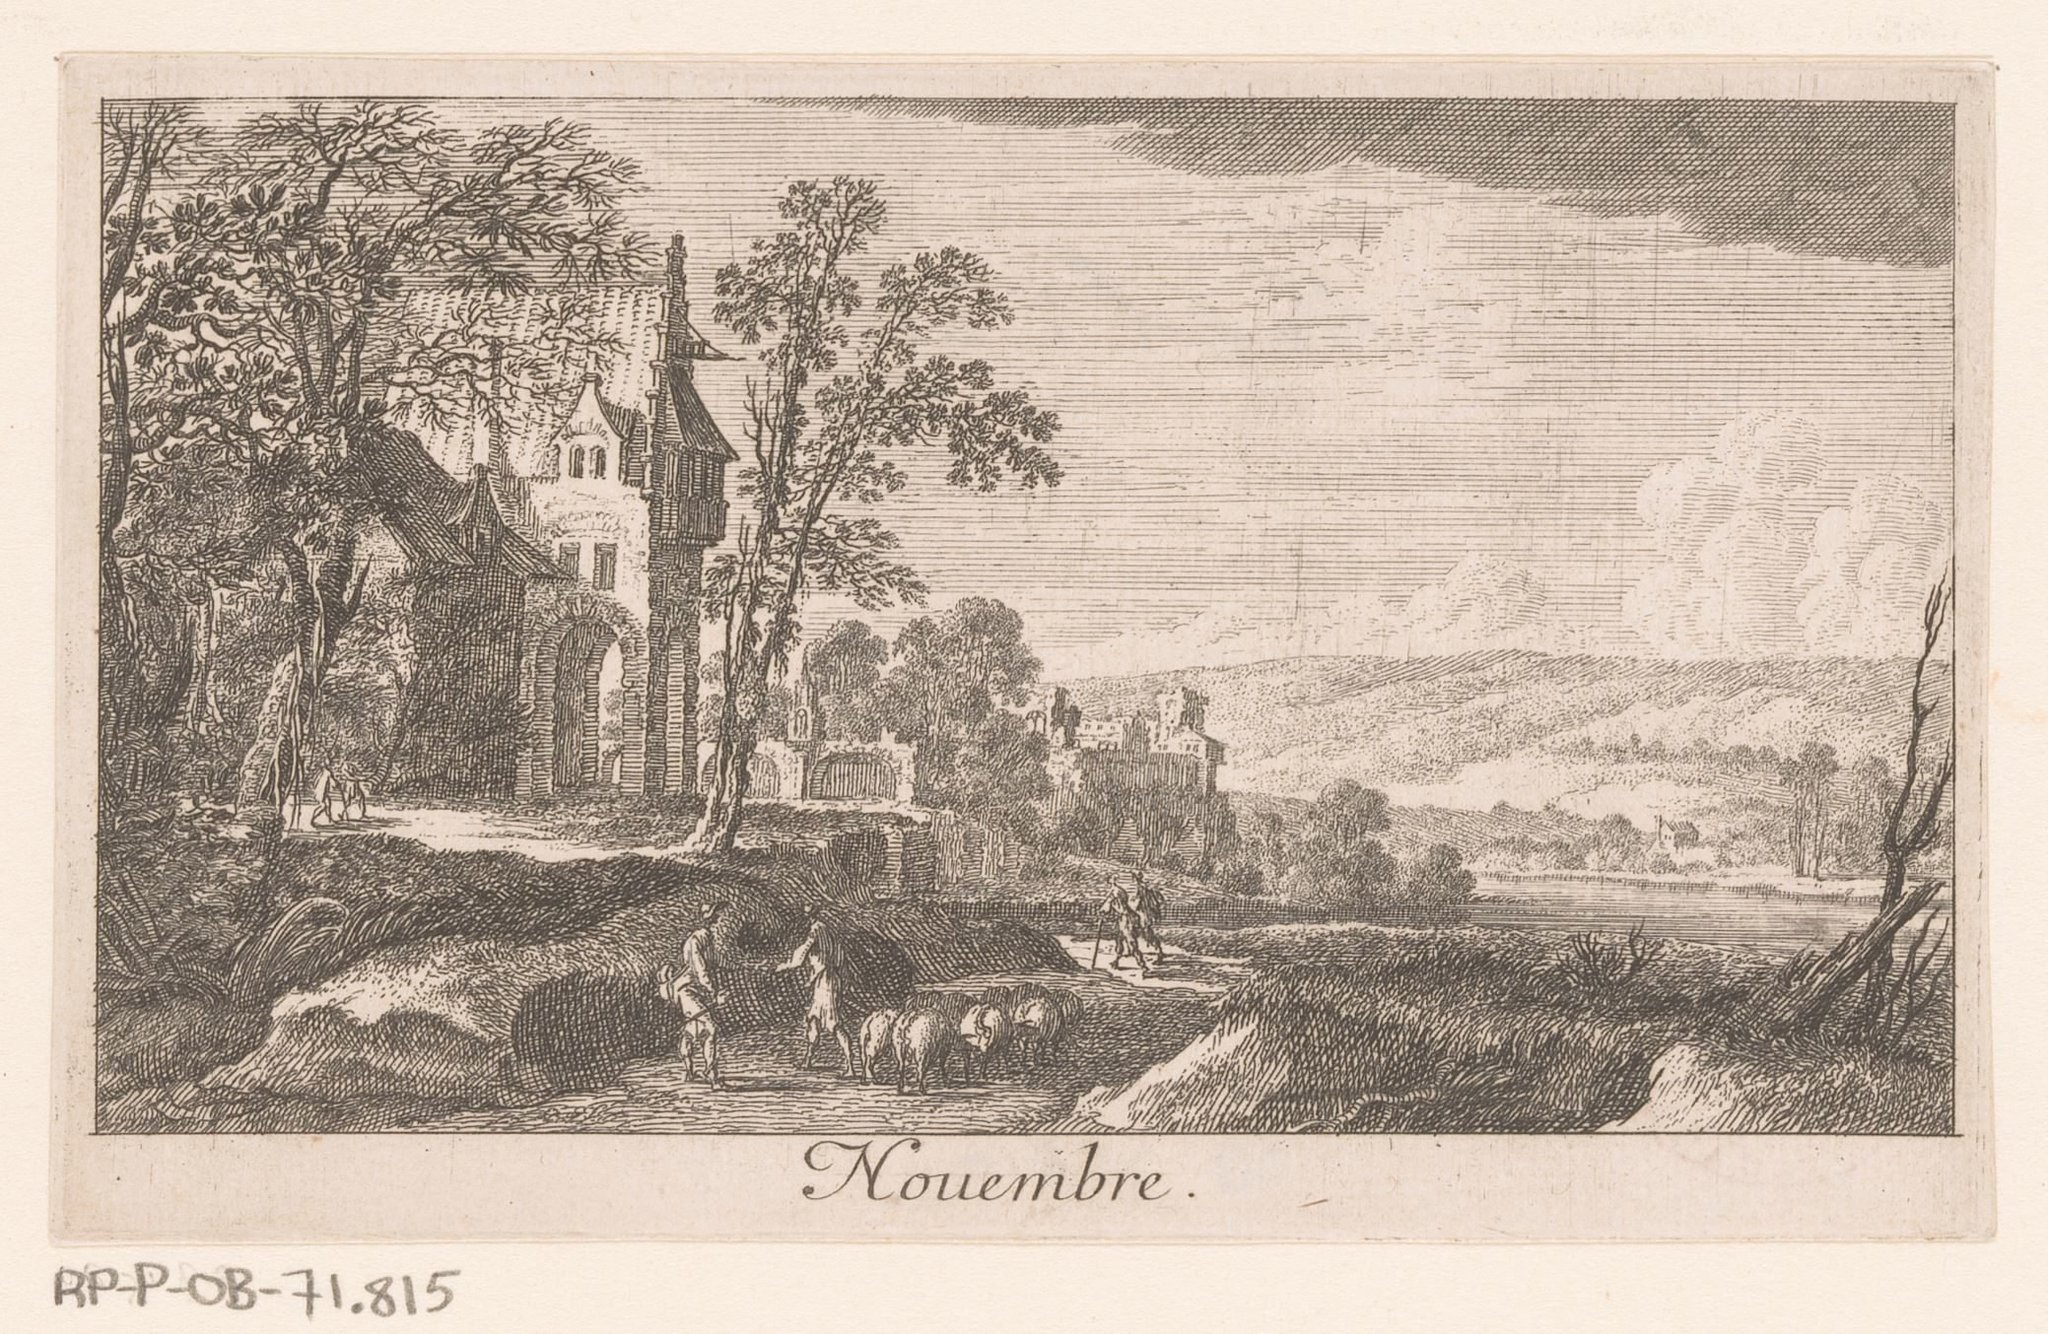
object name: print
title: Novembre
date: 1613-1655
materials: paper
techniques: engraving, etching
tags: landscape symbolizing november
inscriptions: collector's mark: Lugt 240